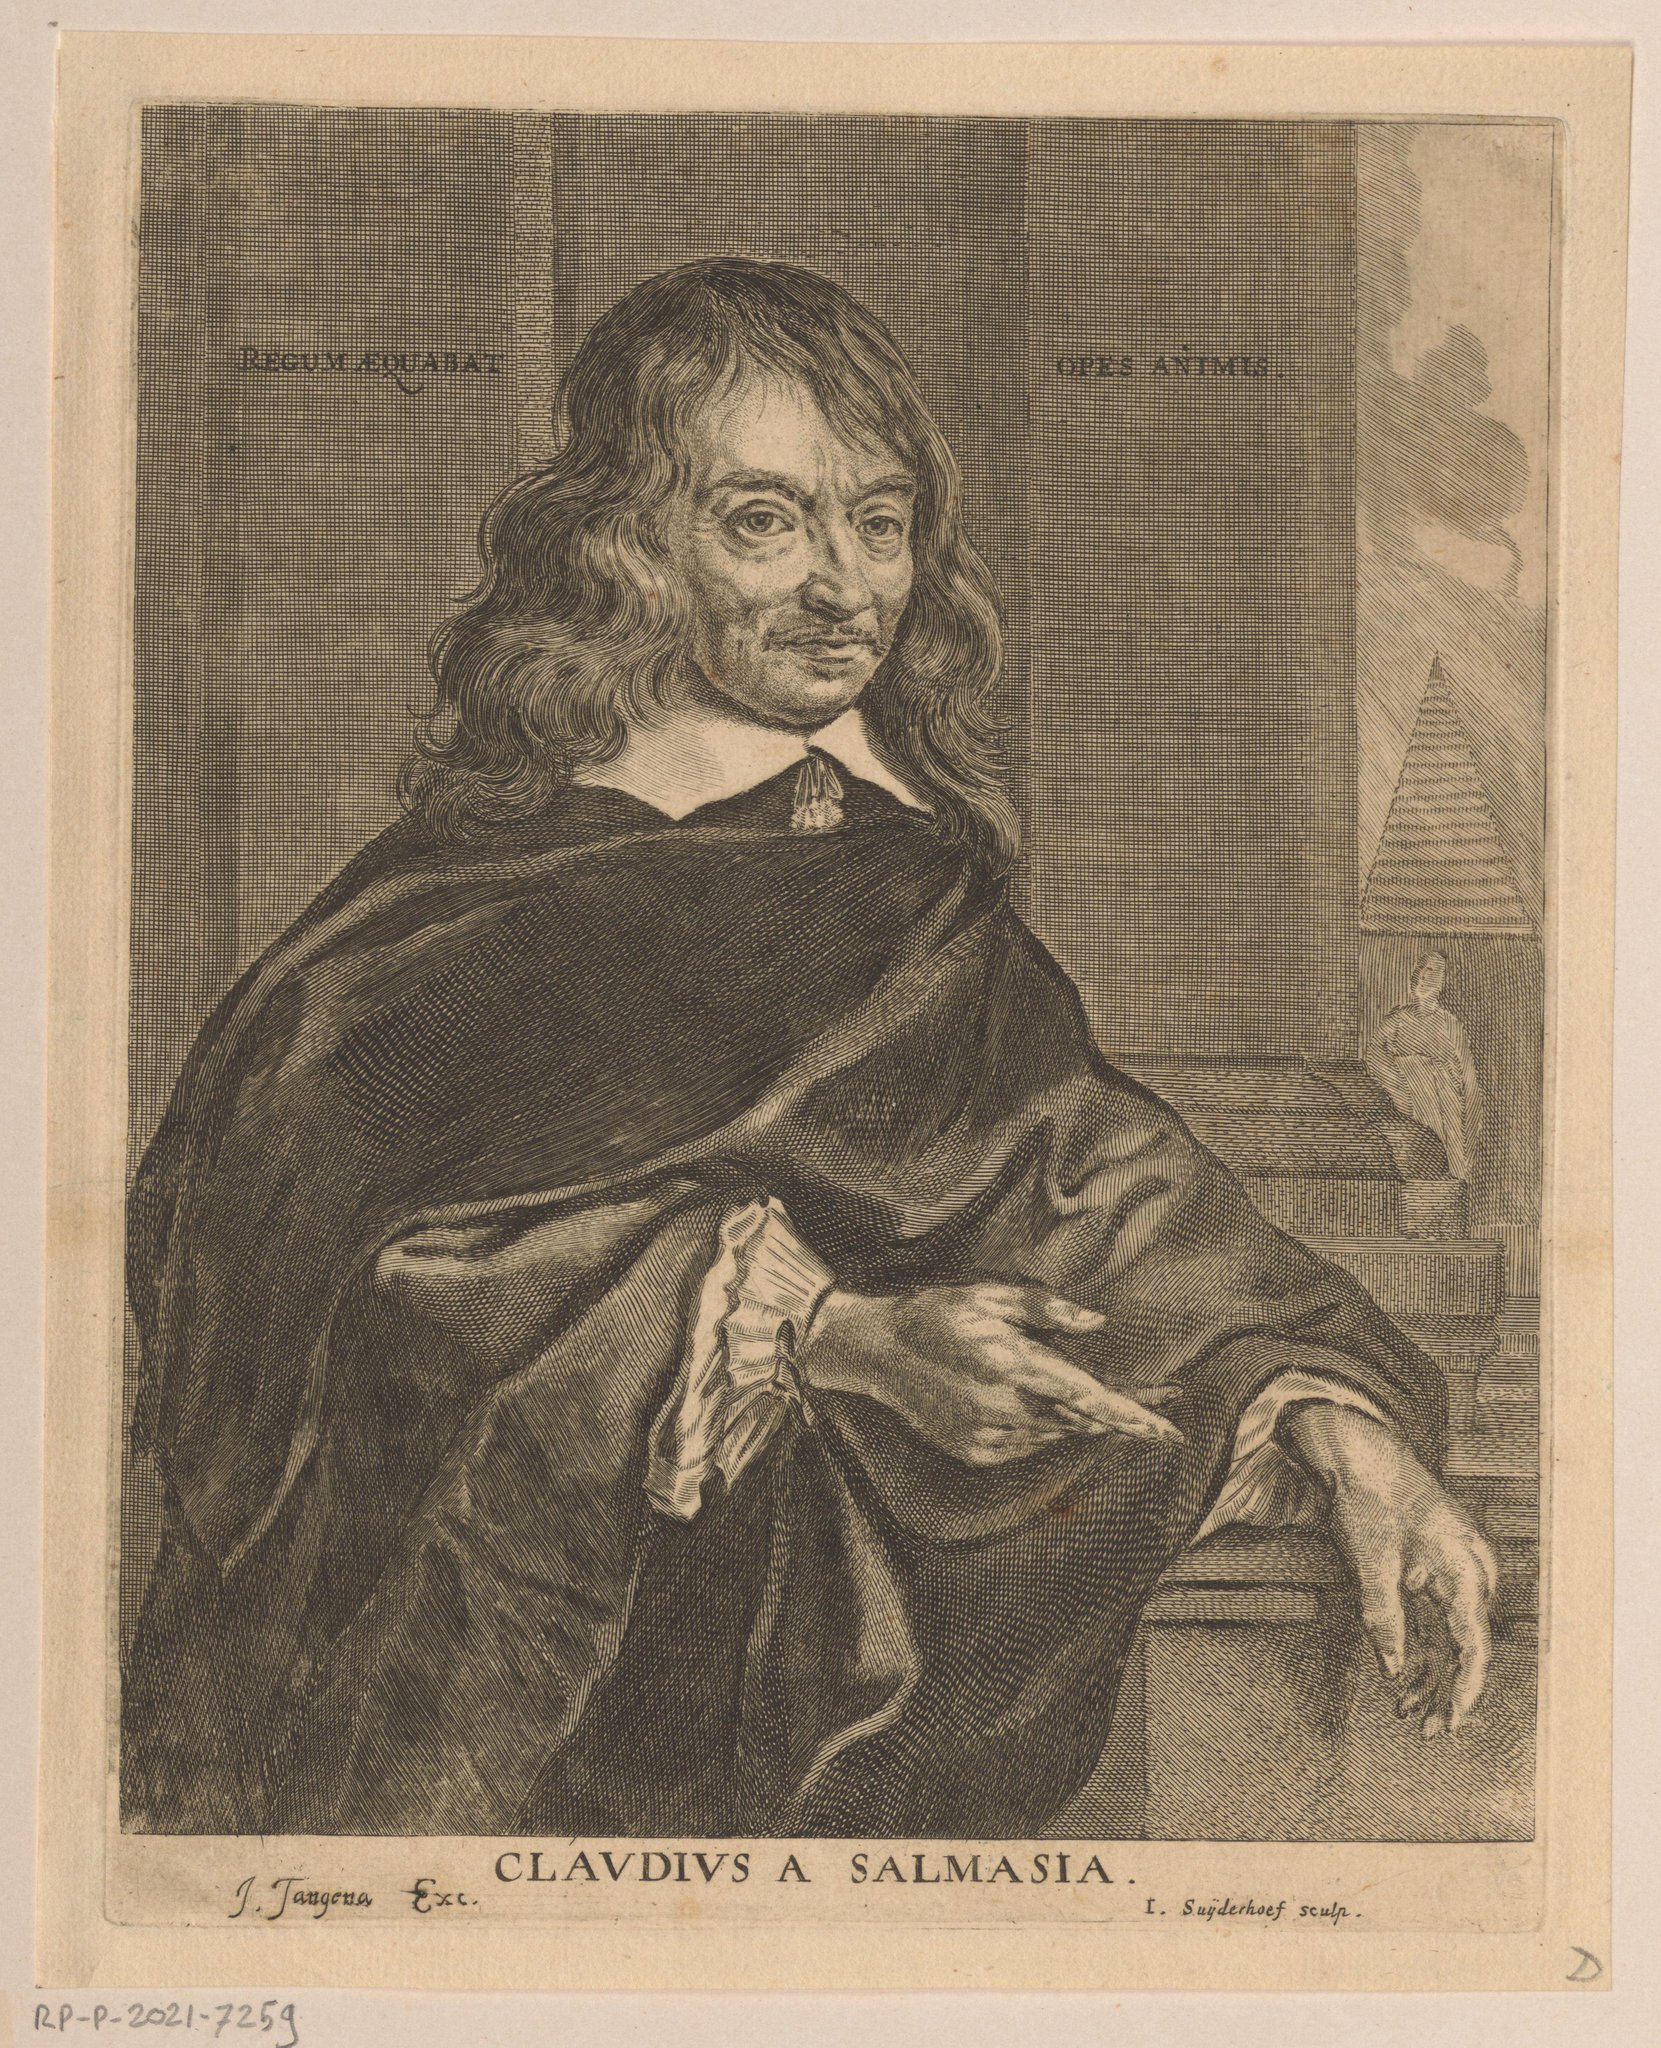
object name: print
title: Portret van Claudius Salmasius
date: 1683-1686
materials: paper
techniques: engraving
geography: leiden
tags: claudius salmasius, historical persons, portrait of a writer